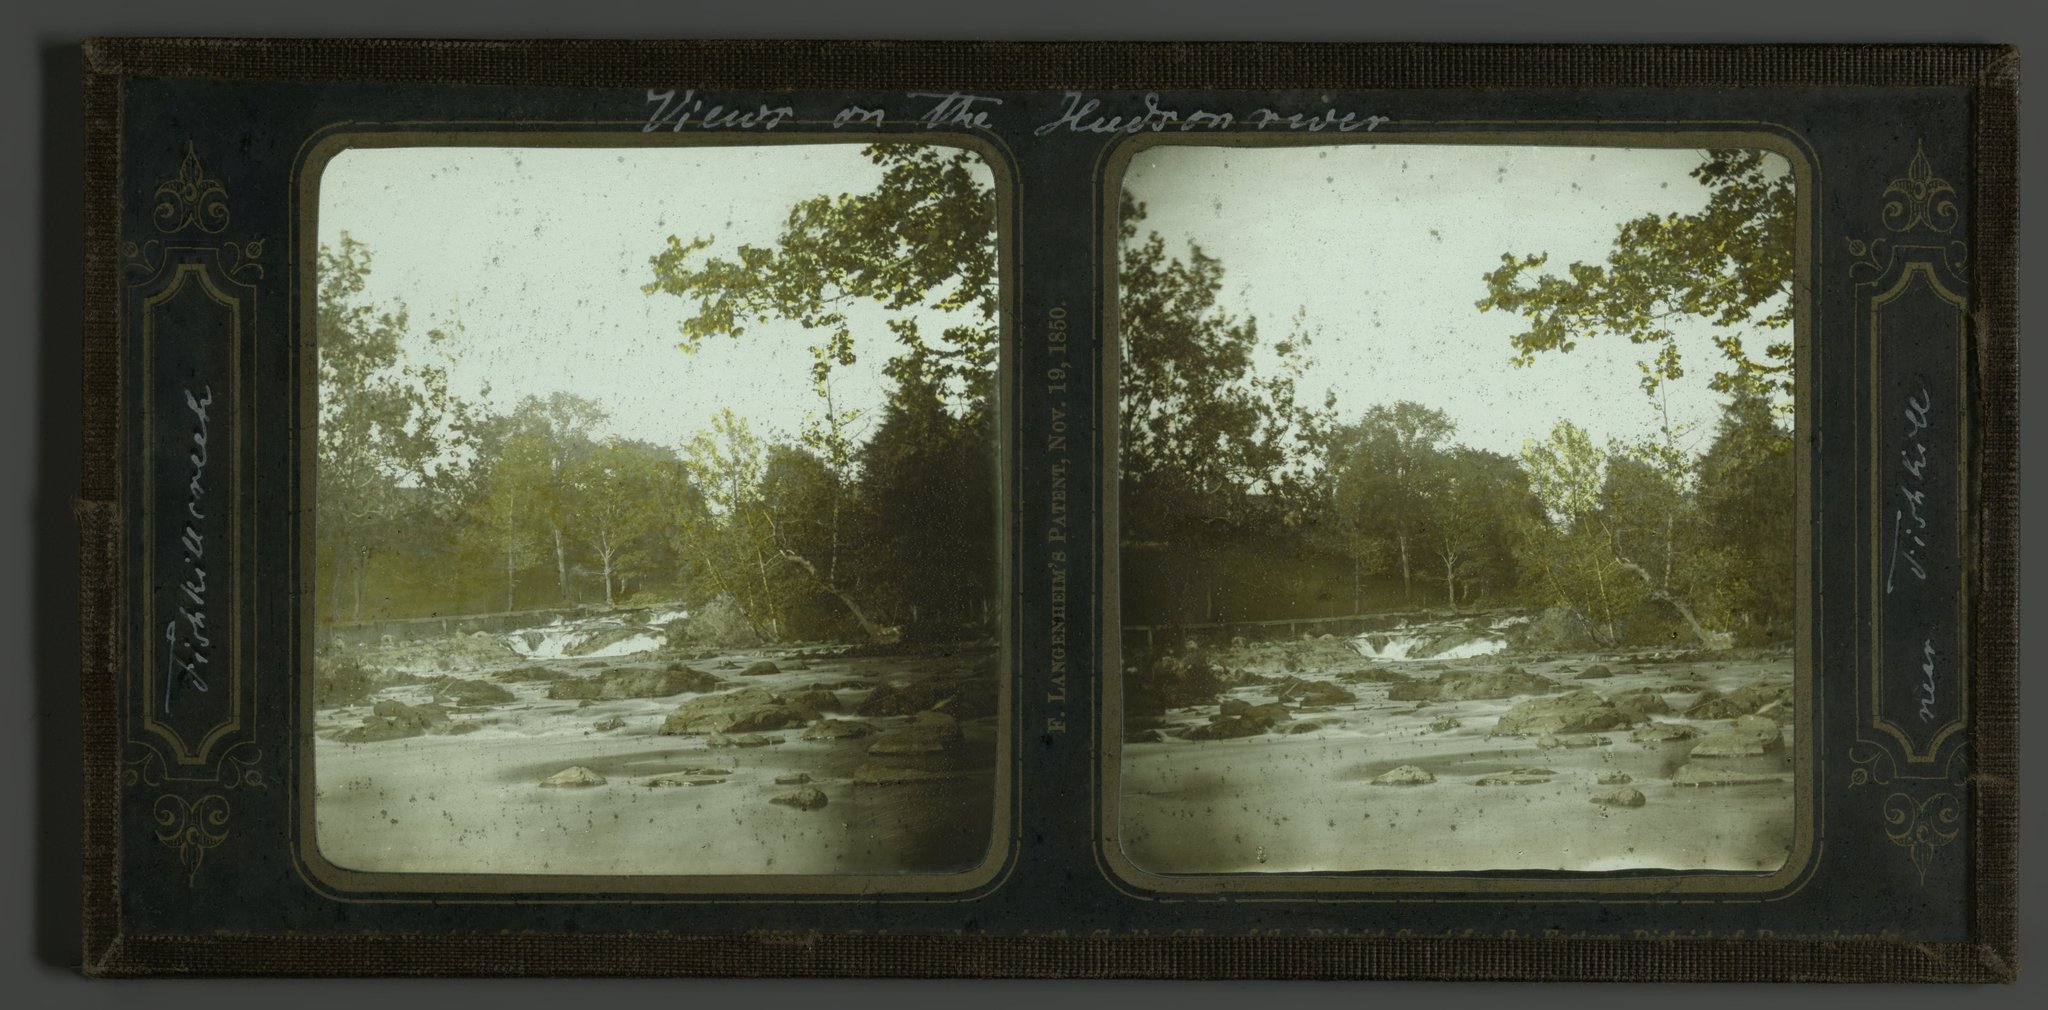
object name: stereoscopic photograph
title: Views on the Hudson river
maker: frederick langenheim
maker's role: fotograaf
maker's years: 1809-1879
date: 1856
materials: glass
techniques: hand coloring, slide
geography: fishkill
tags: brook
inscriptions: inscription: ‘F. Langenheim's Patent, Nov. 19, 1850.’, inscription: ‘Entered according to Act of Congress, in the year 1856, by F. Langenheim, in the Clerk's Office of the District Court for the Eastern District of Pennsylvania.’